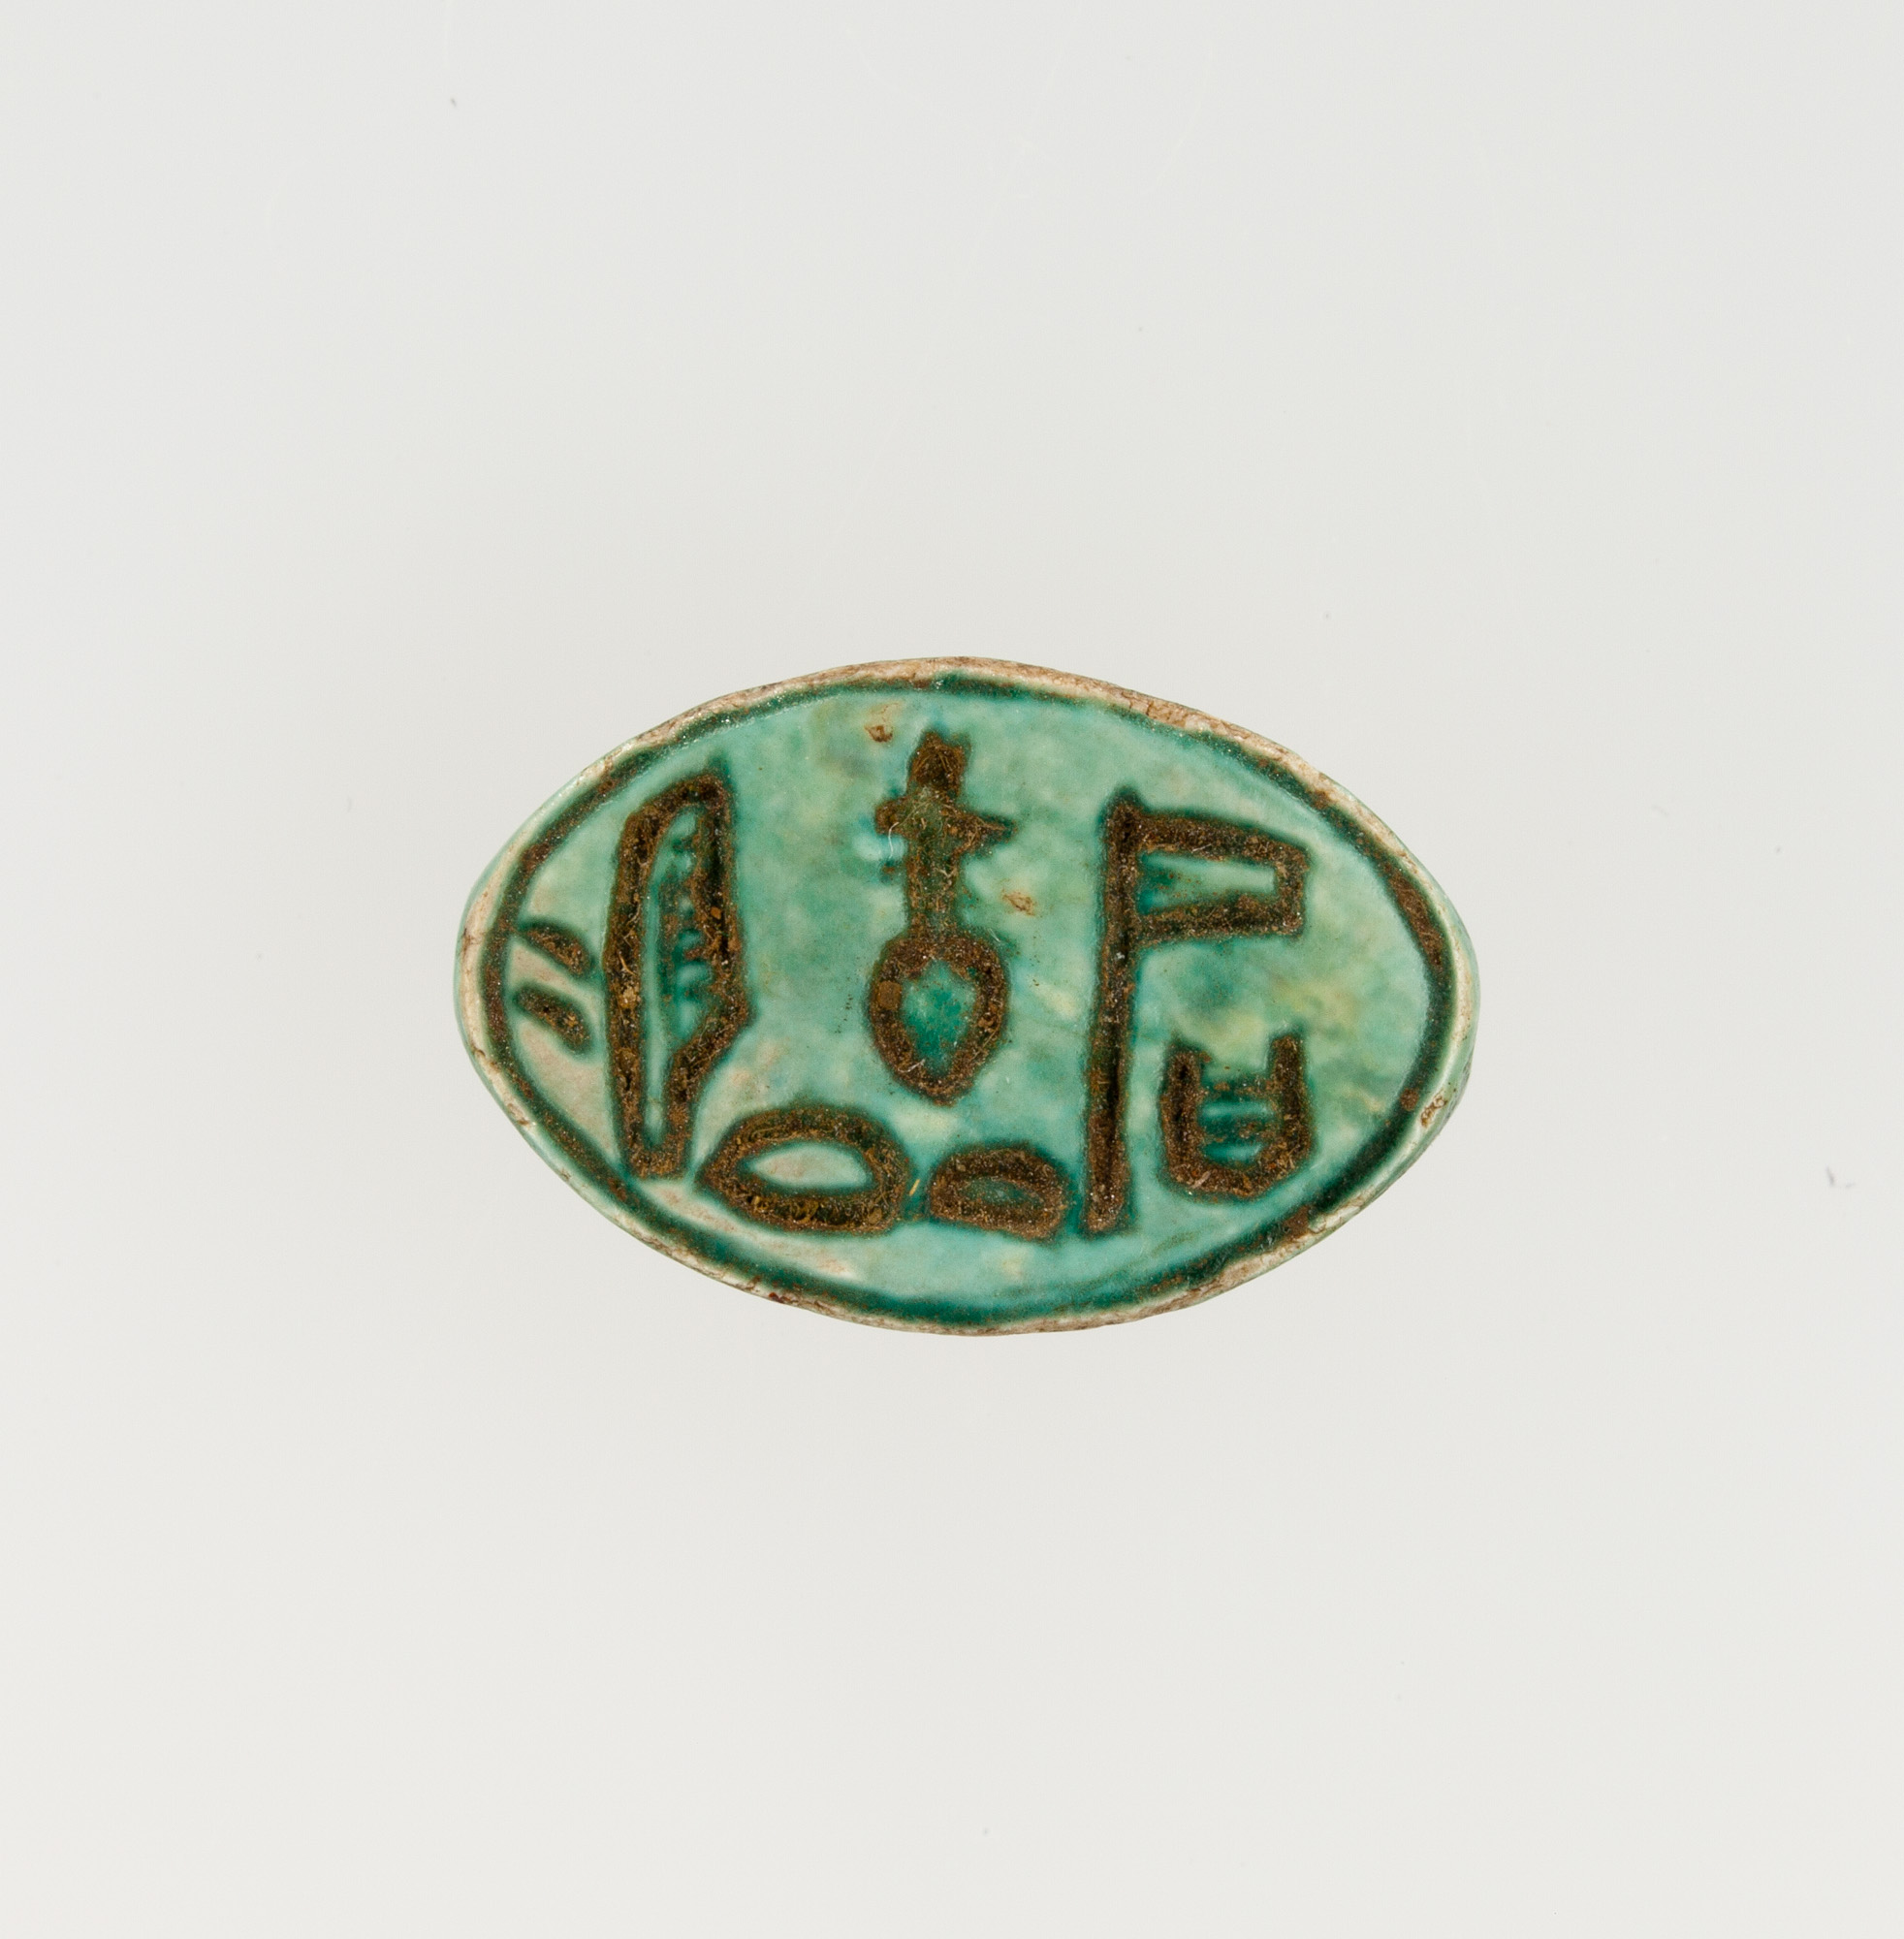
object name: cowroid, ahmose nefertari, god's wife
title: Stamp Seal Inscribed for the God's Wife Nefertari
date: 1550-1525 BCE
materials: stone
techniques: glazing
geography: egypt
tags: hieroglyphs